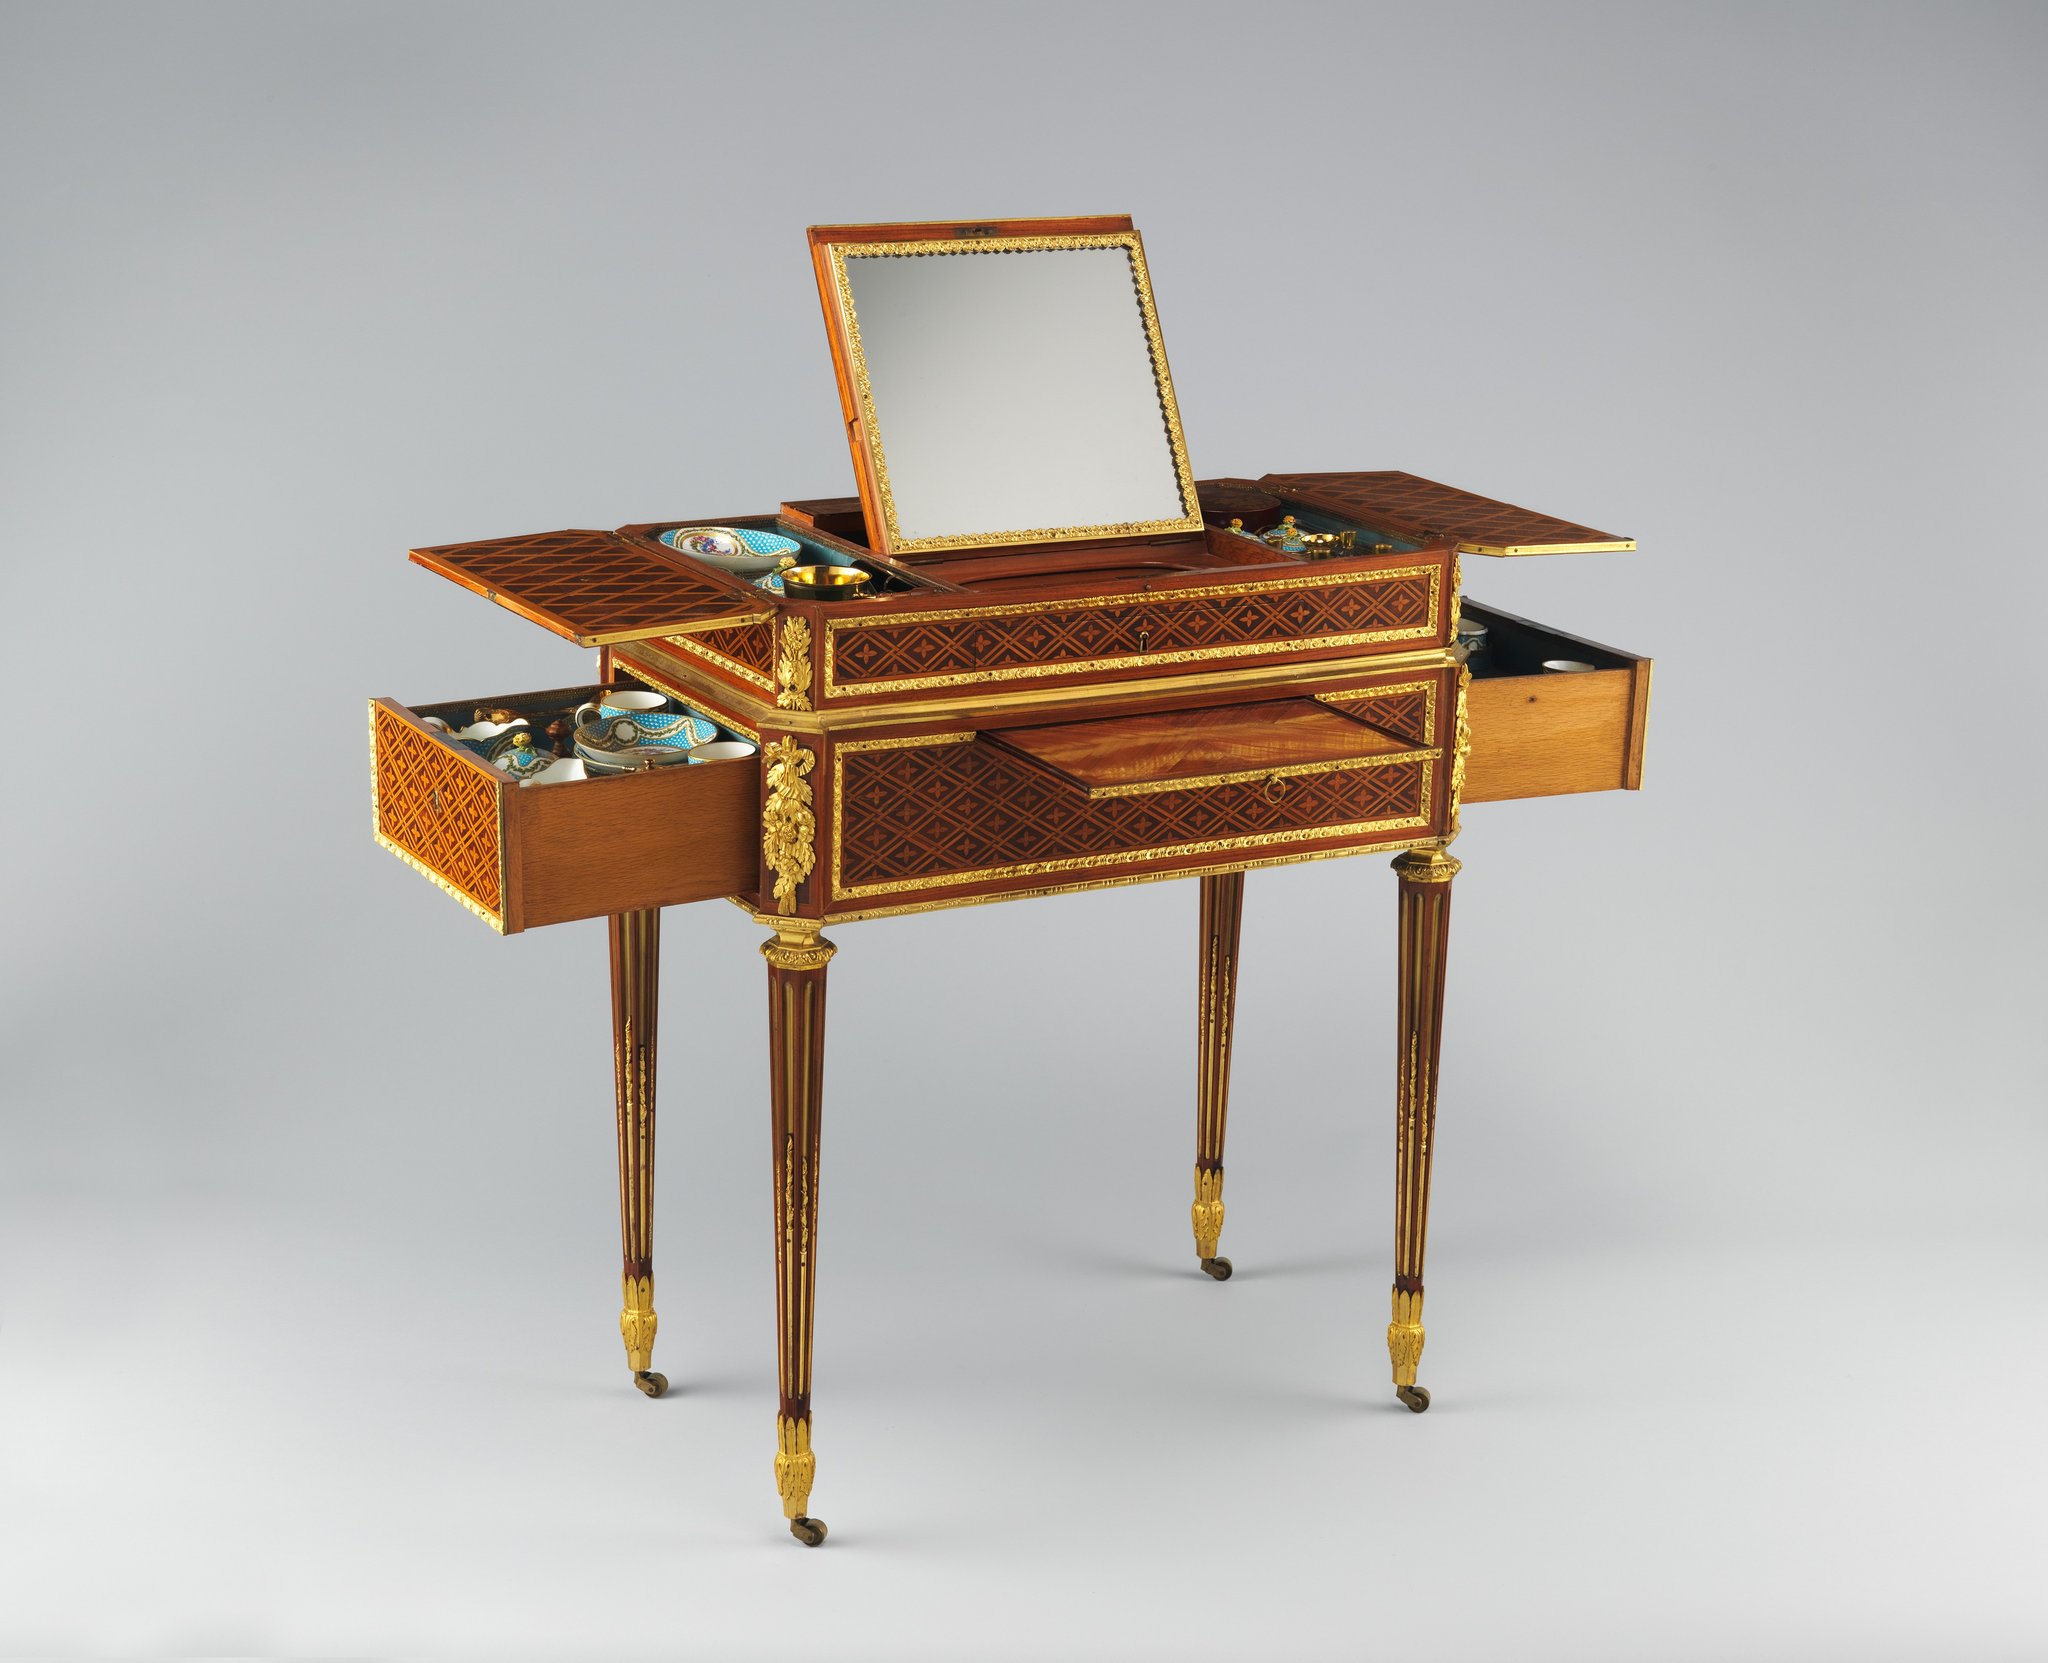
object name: combination table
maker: martin carlin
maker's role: maker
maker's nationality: french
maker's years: 1725-1785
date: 1775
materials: wood, gilt bronze, lacquer, marble, porcelain, quartz, silver gilt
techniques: veneering